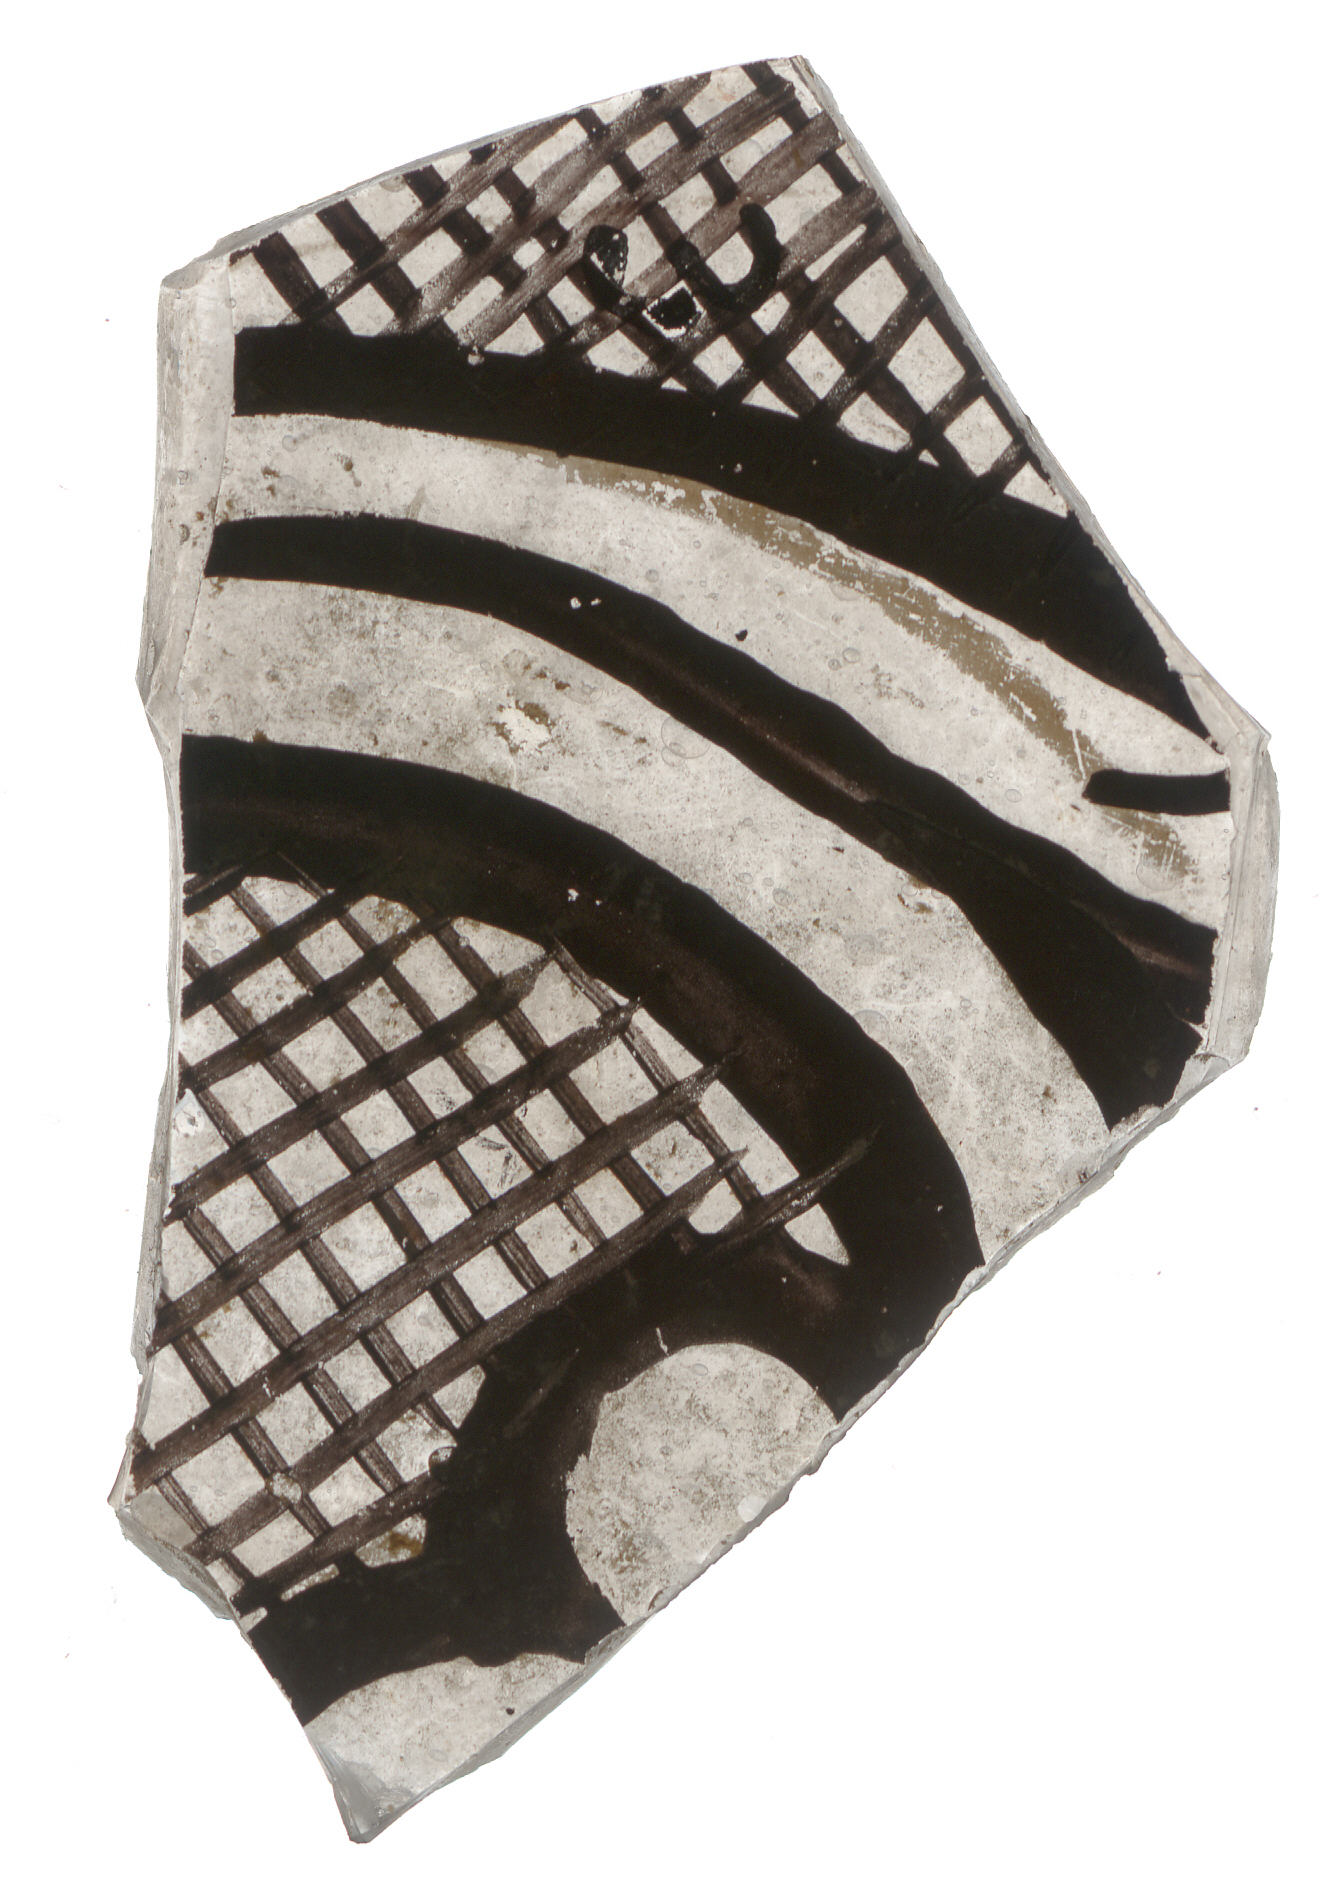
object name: fragment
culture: crusader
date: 1201-1300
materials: glass